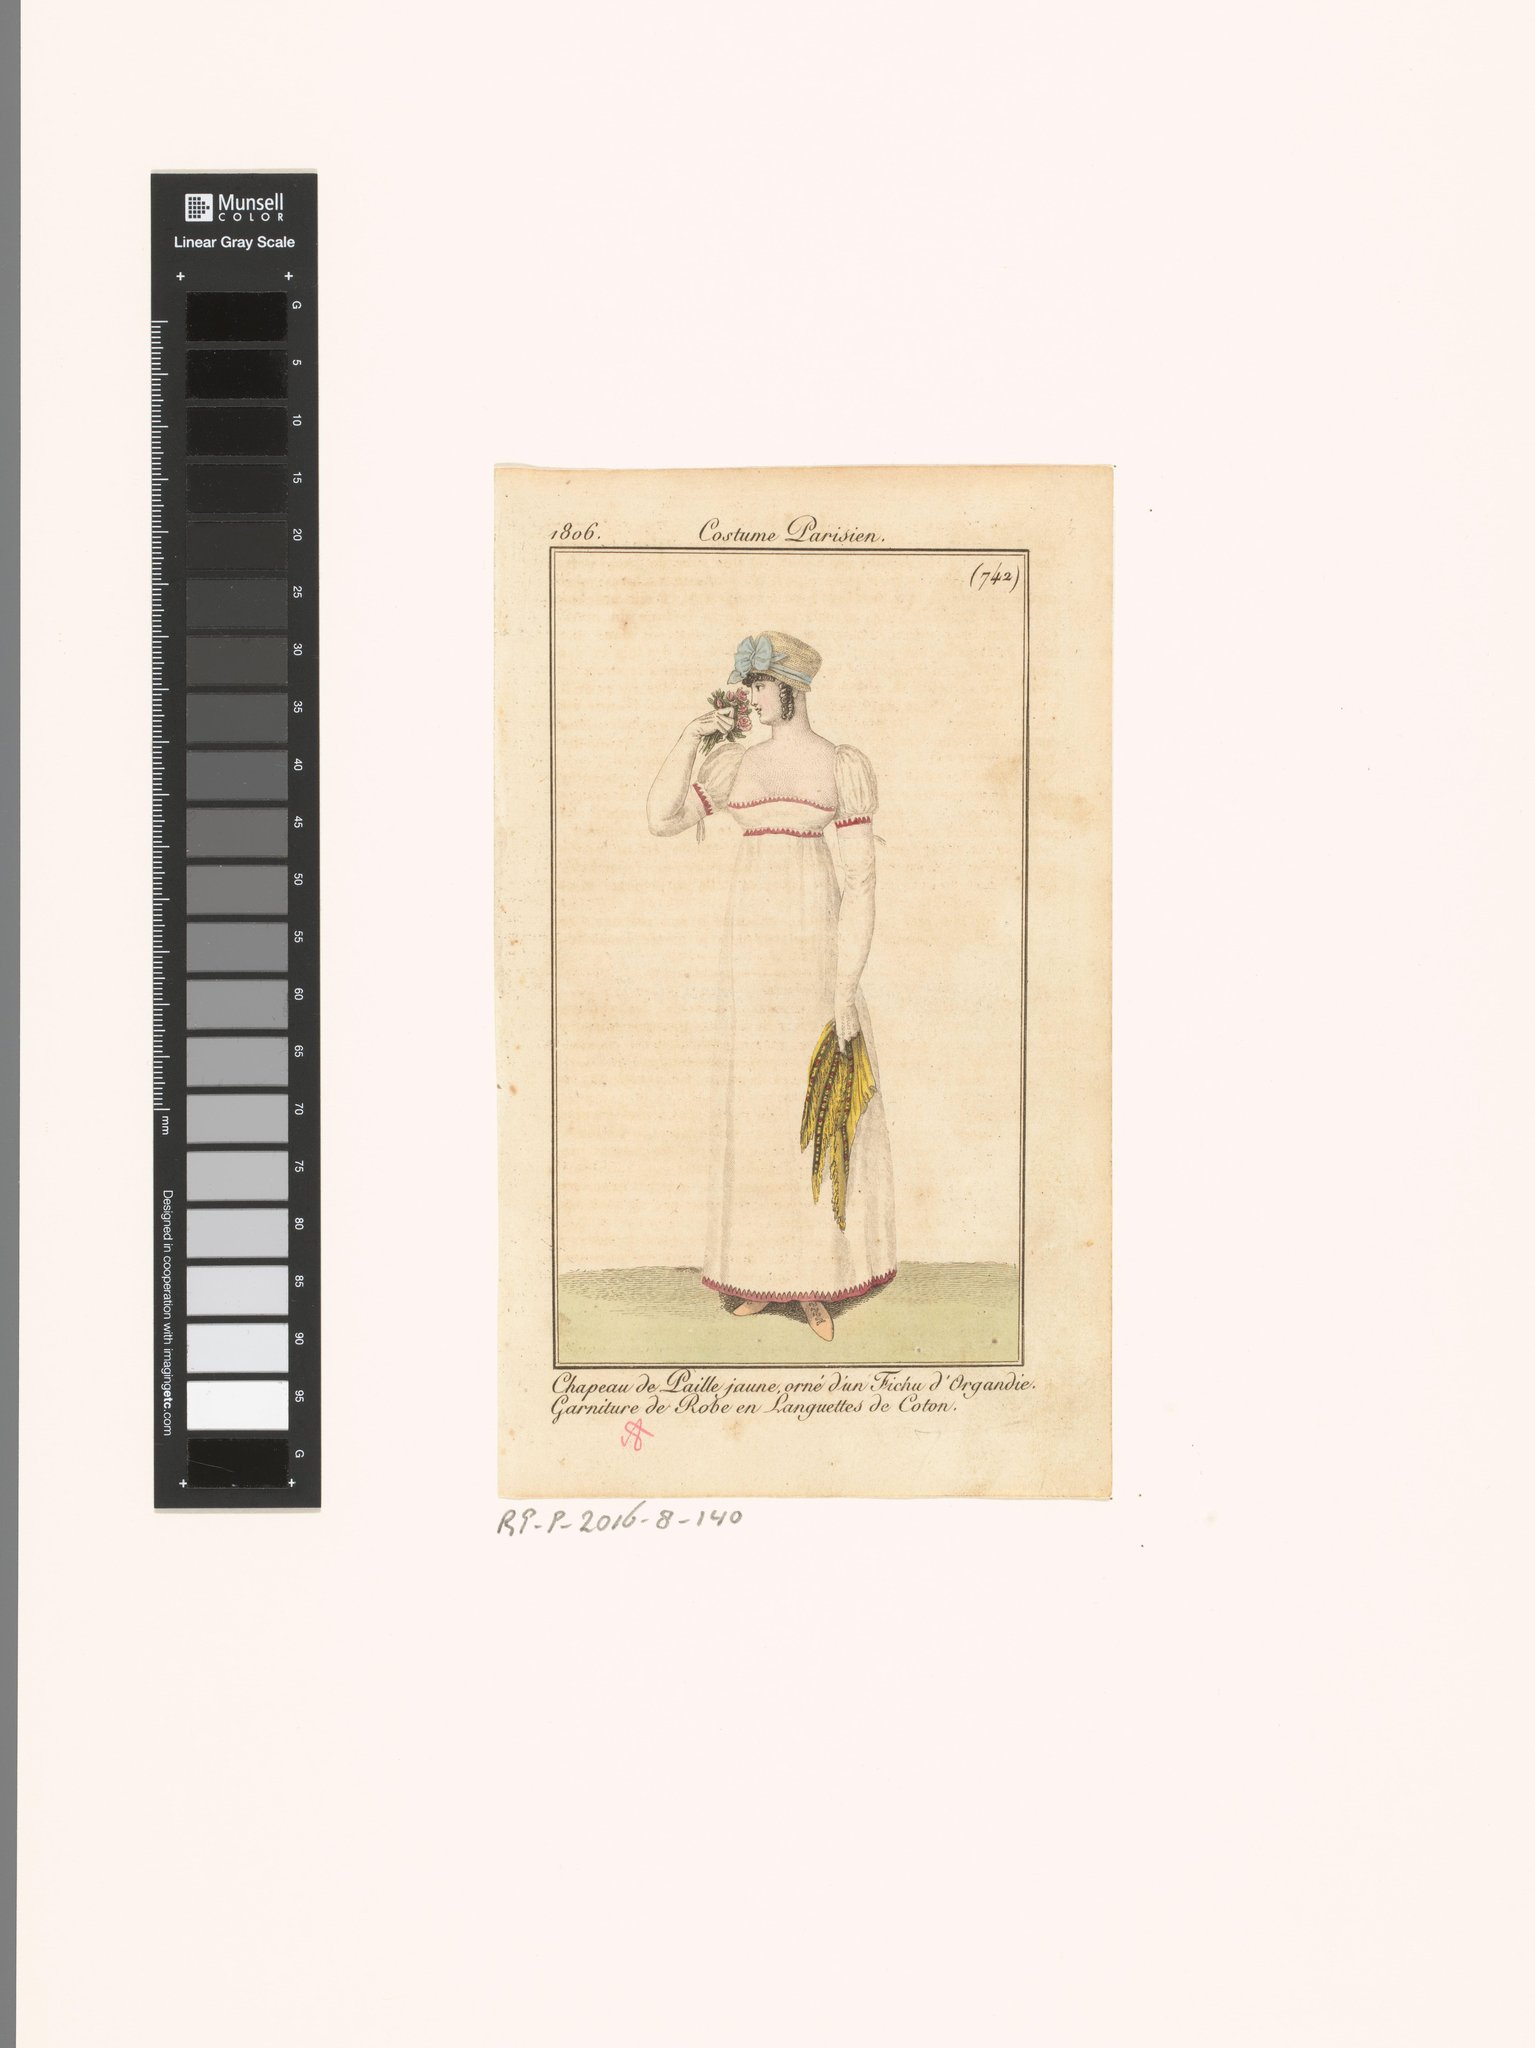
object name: fashion print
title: Journal des Dames et des modes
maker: Anonymous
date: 1806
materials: paper, ink, watercolor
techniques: etching, hand coloring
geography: europe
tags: fashion plates